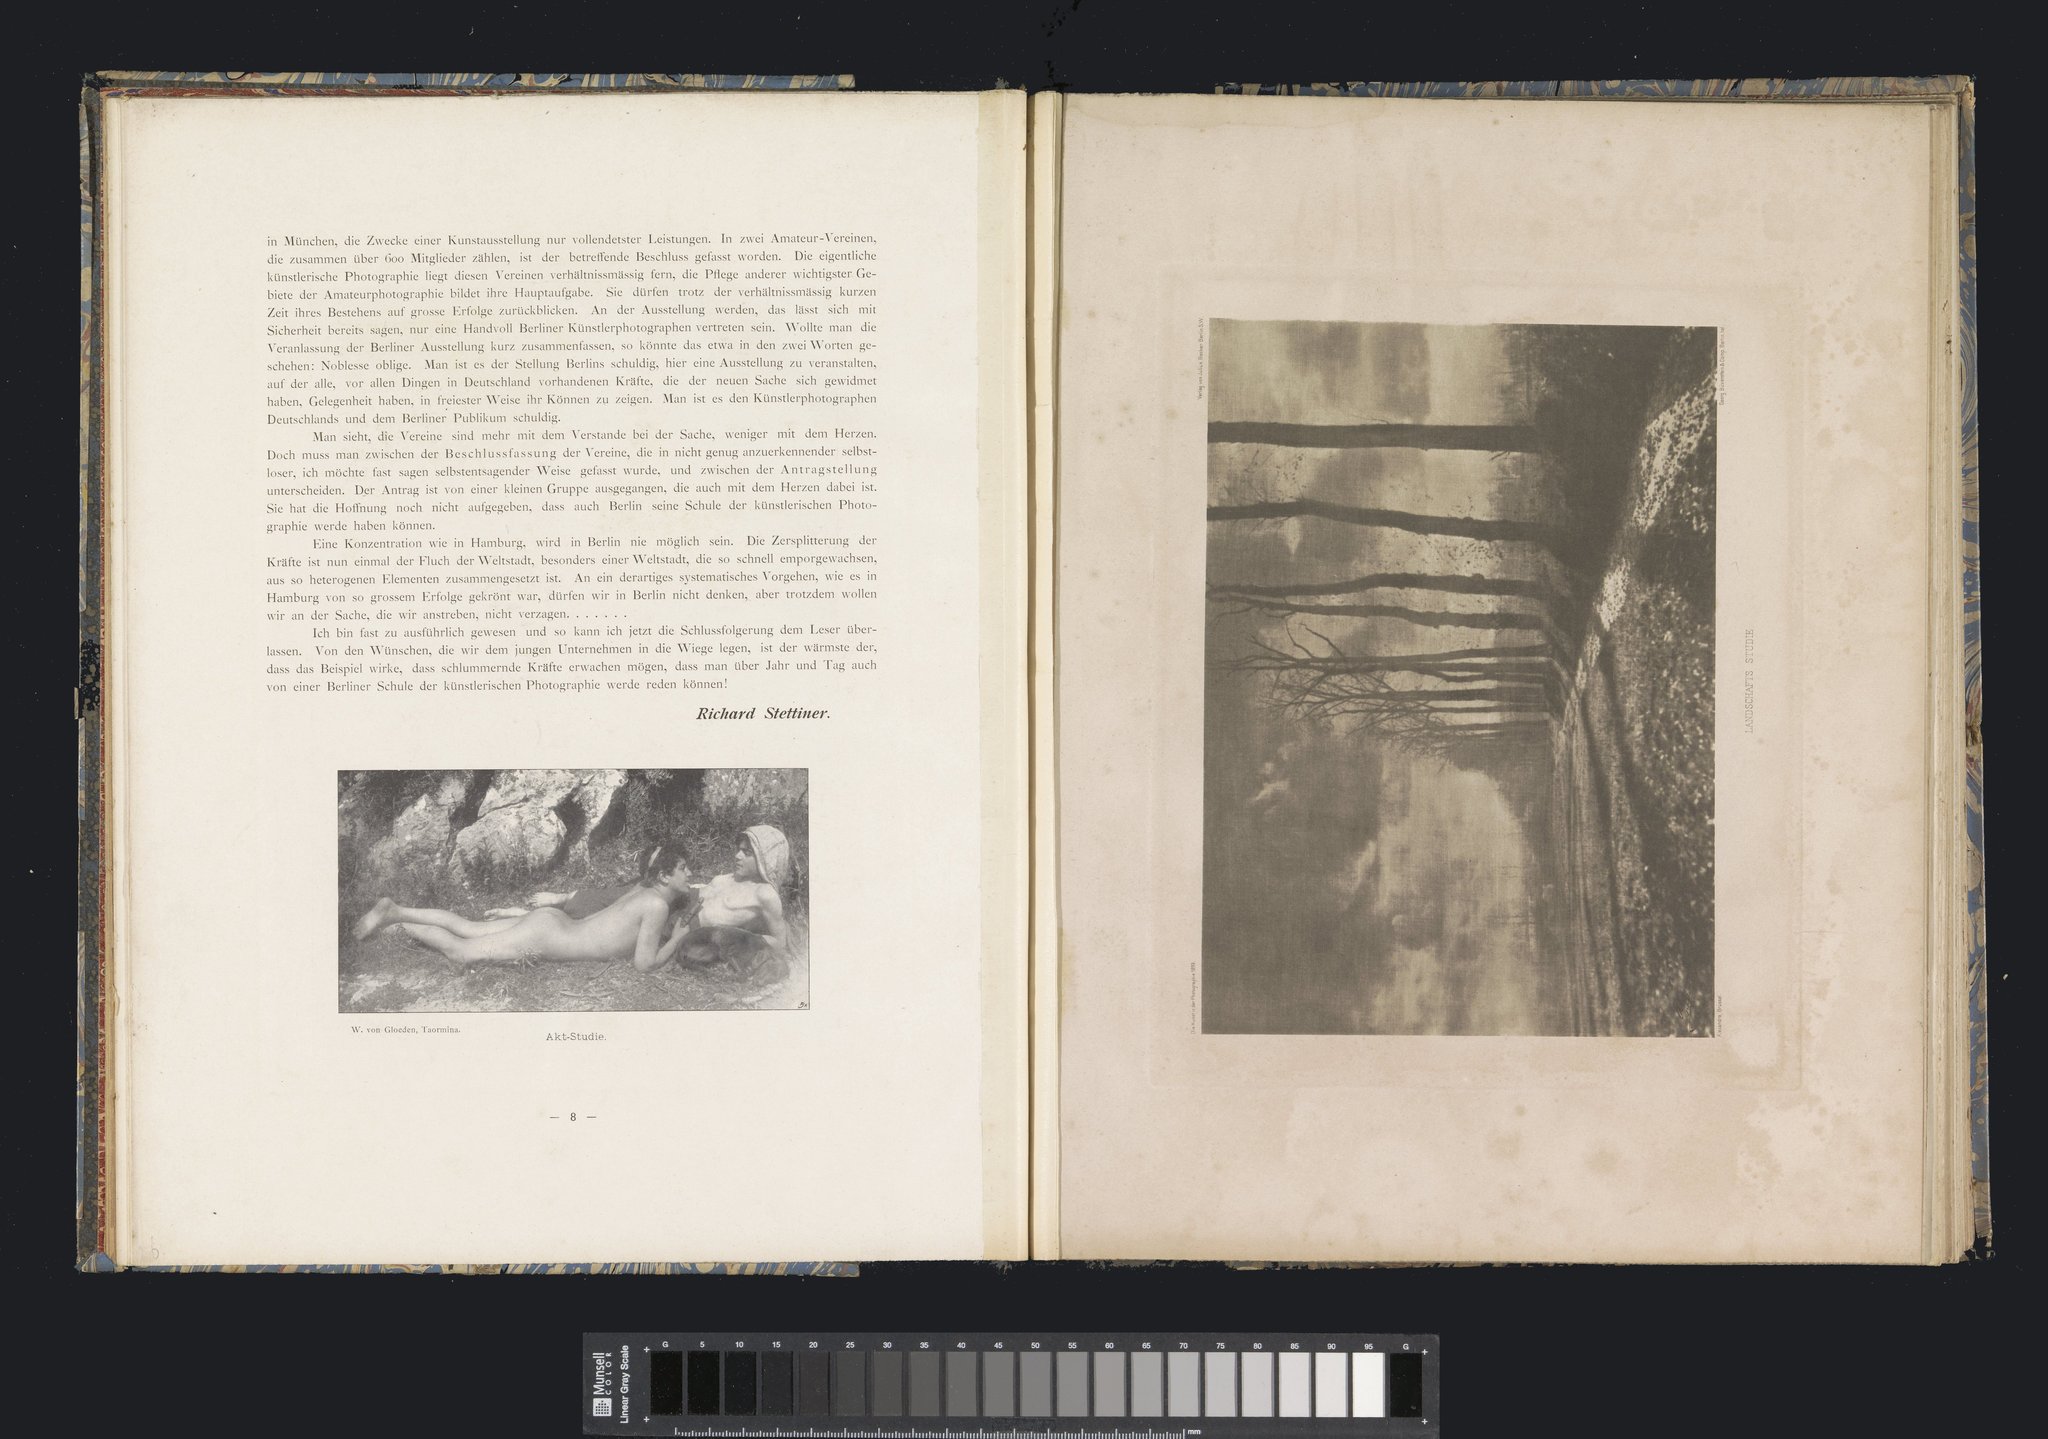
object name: photomechanical print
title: Landschafts Studie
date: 1889-1899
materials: paper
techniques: photoaquatint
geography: berlin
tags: trees, landscapes in the temperate zone